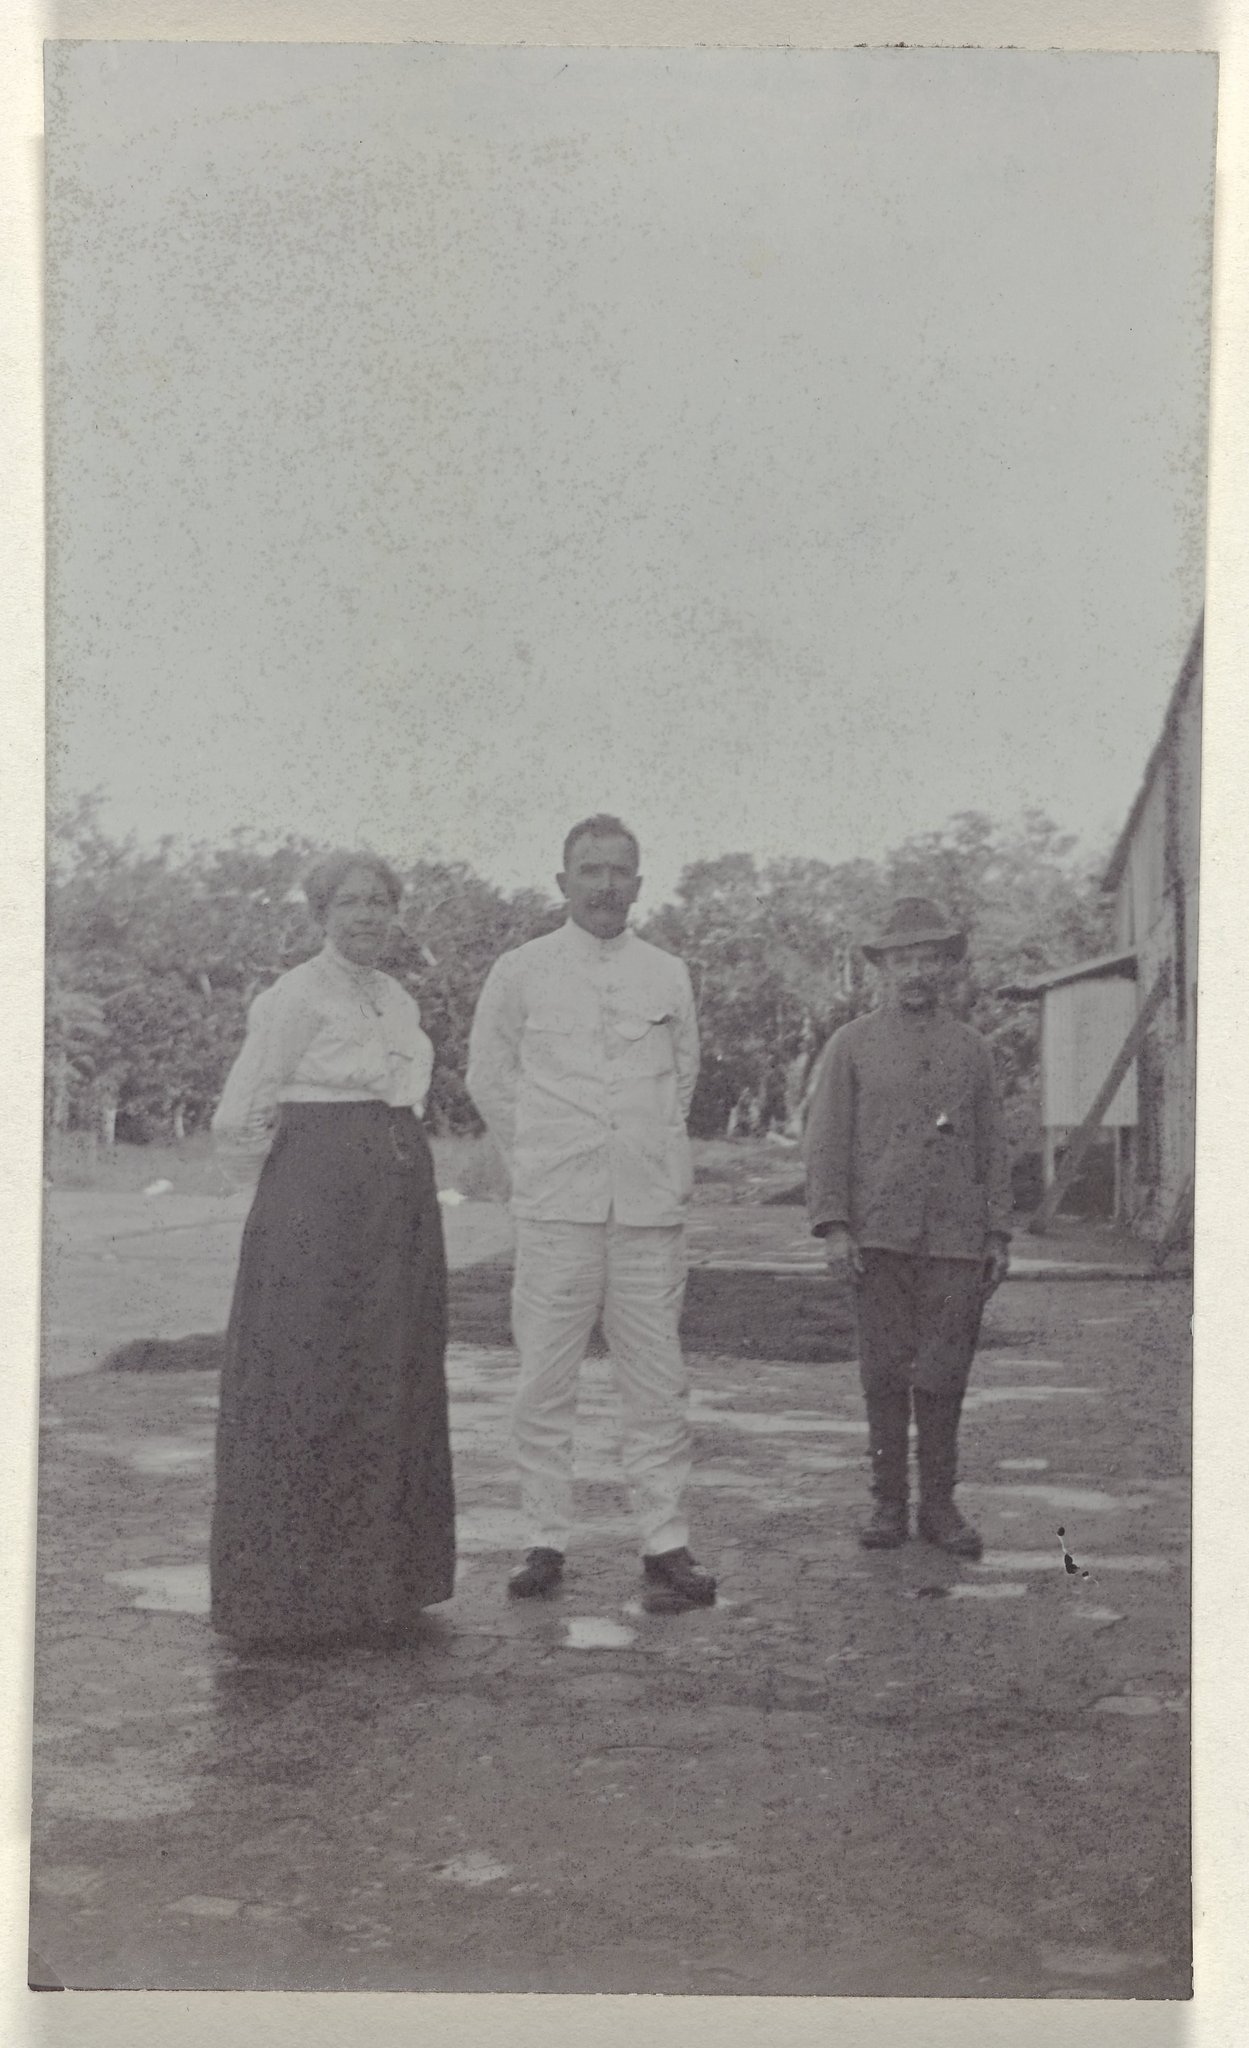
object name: photograph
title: Echtpaar Justus Gonggrijp en Anna Rühmann-Gonggrijp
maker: Anonymous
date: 1912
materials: photographic support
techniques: photography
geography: suriname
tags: justus gonggrijp, suriname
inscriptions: date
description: Het echtpaar Justus Gonggrijp en Anna Rühmann-Gonggrijp op een plantage in Suriname. Onderdeel van een groep foto's van de familie Boom-Gonggrijp in Suriname.